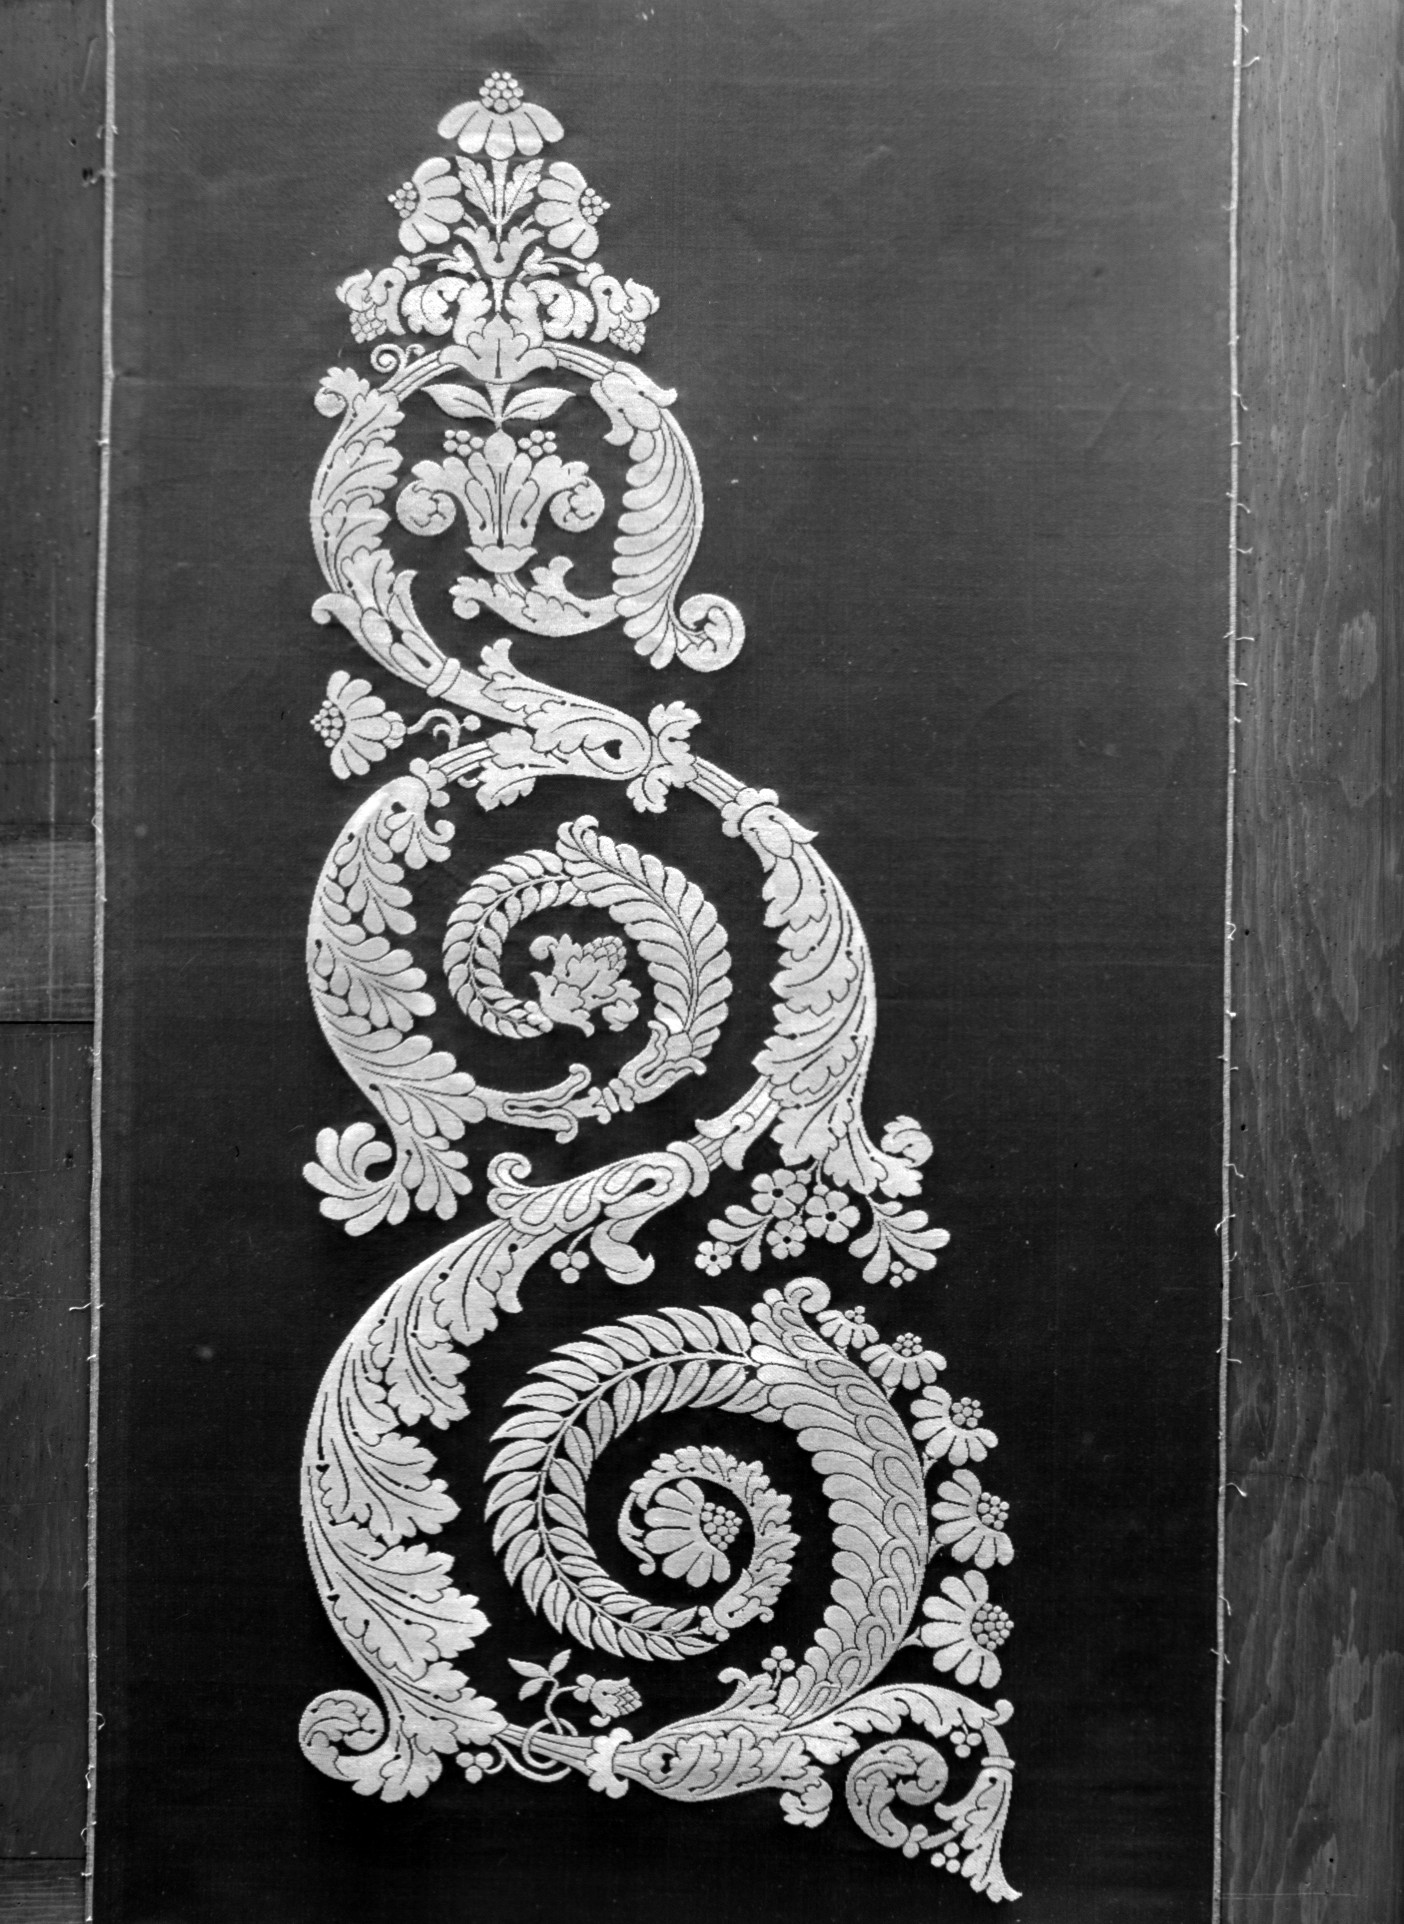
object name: length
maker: séguin et cie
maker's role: manufactory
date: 1805-1815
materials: metal thread, silk